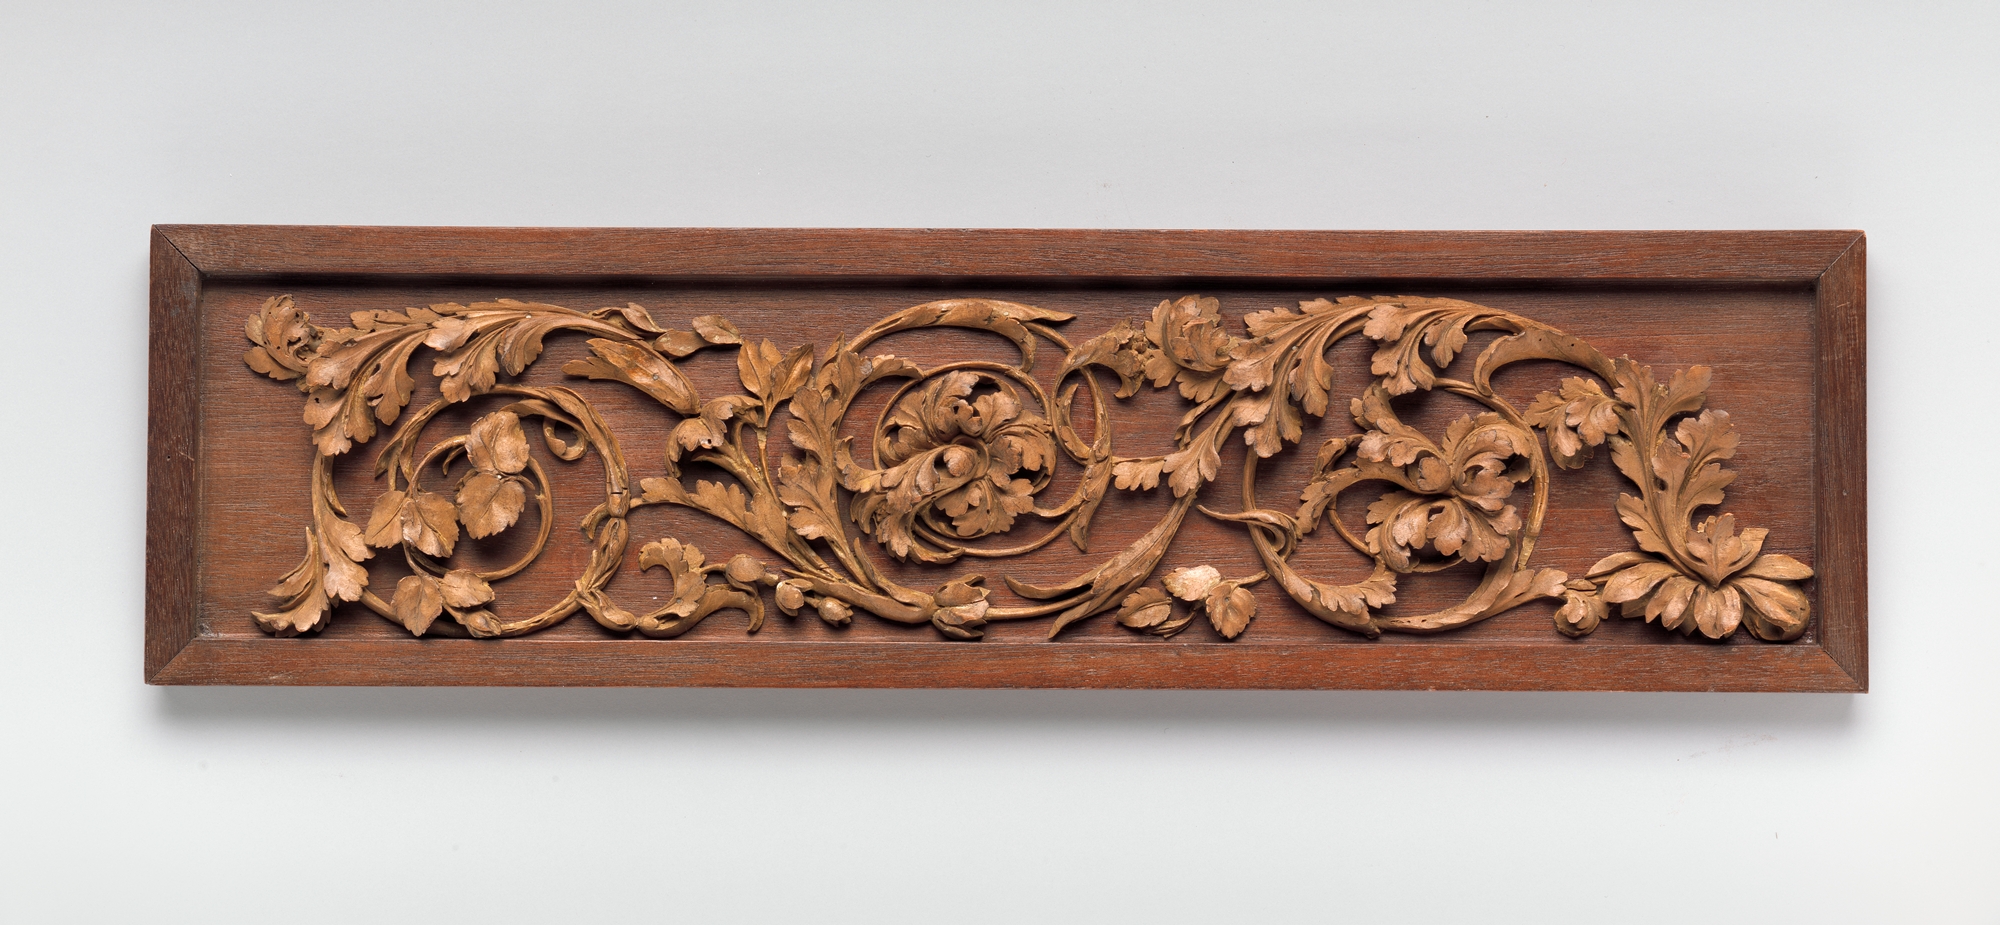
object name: panel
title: Panel (one of a pair)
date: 1701-1800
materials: wood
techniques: carving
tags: leaves